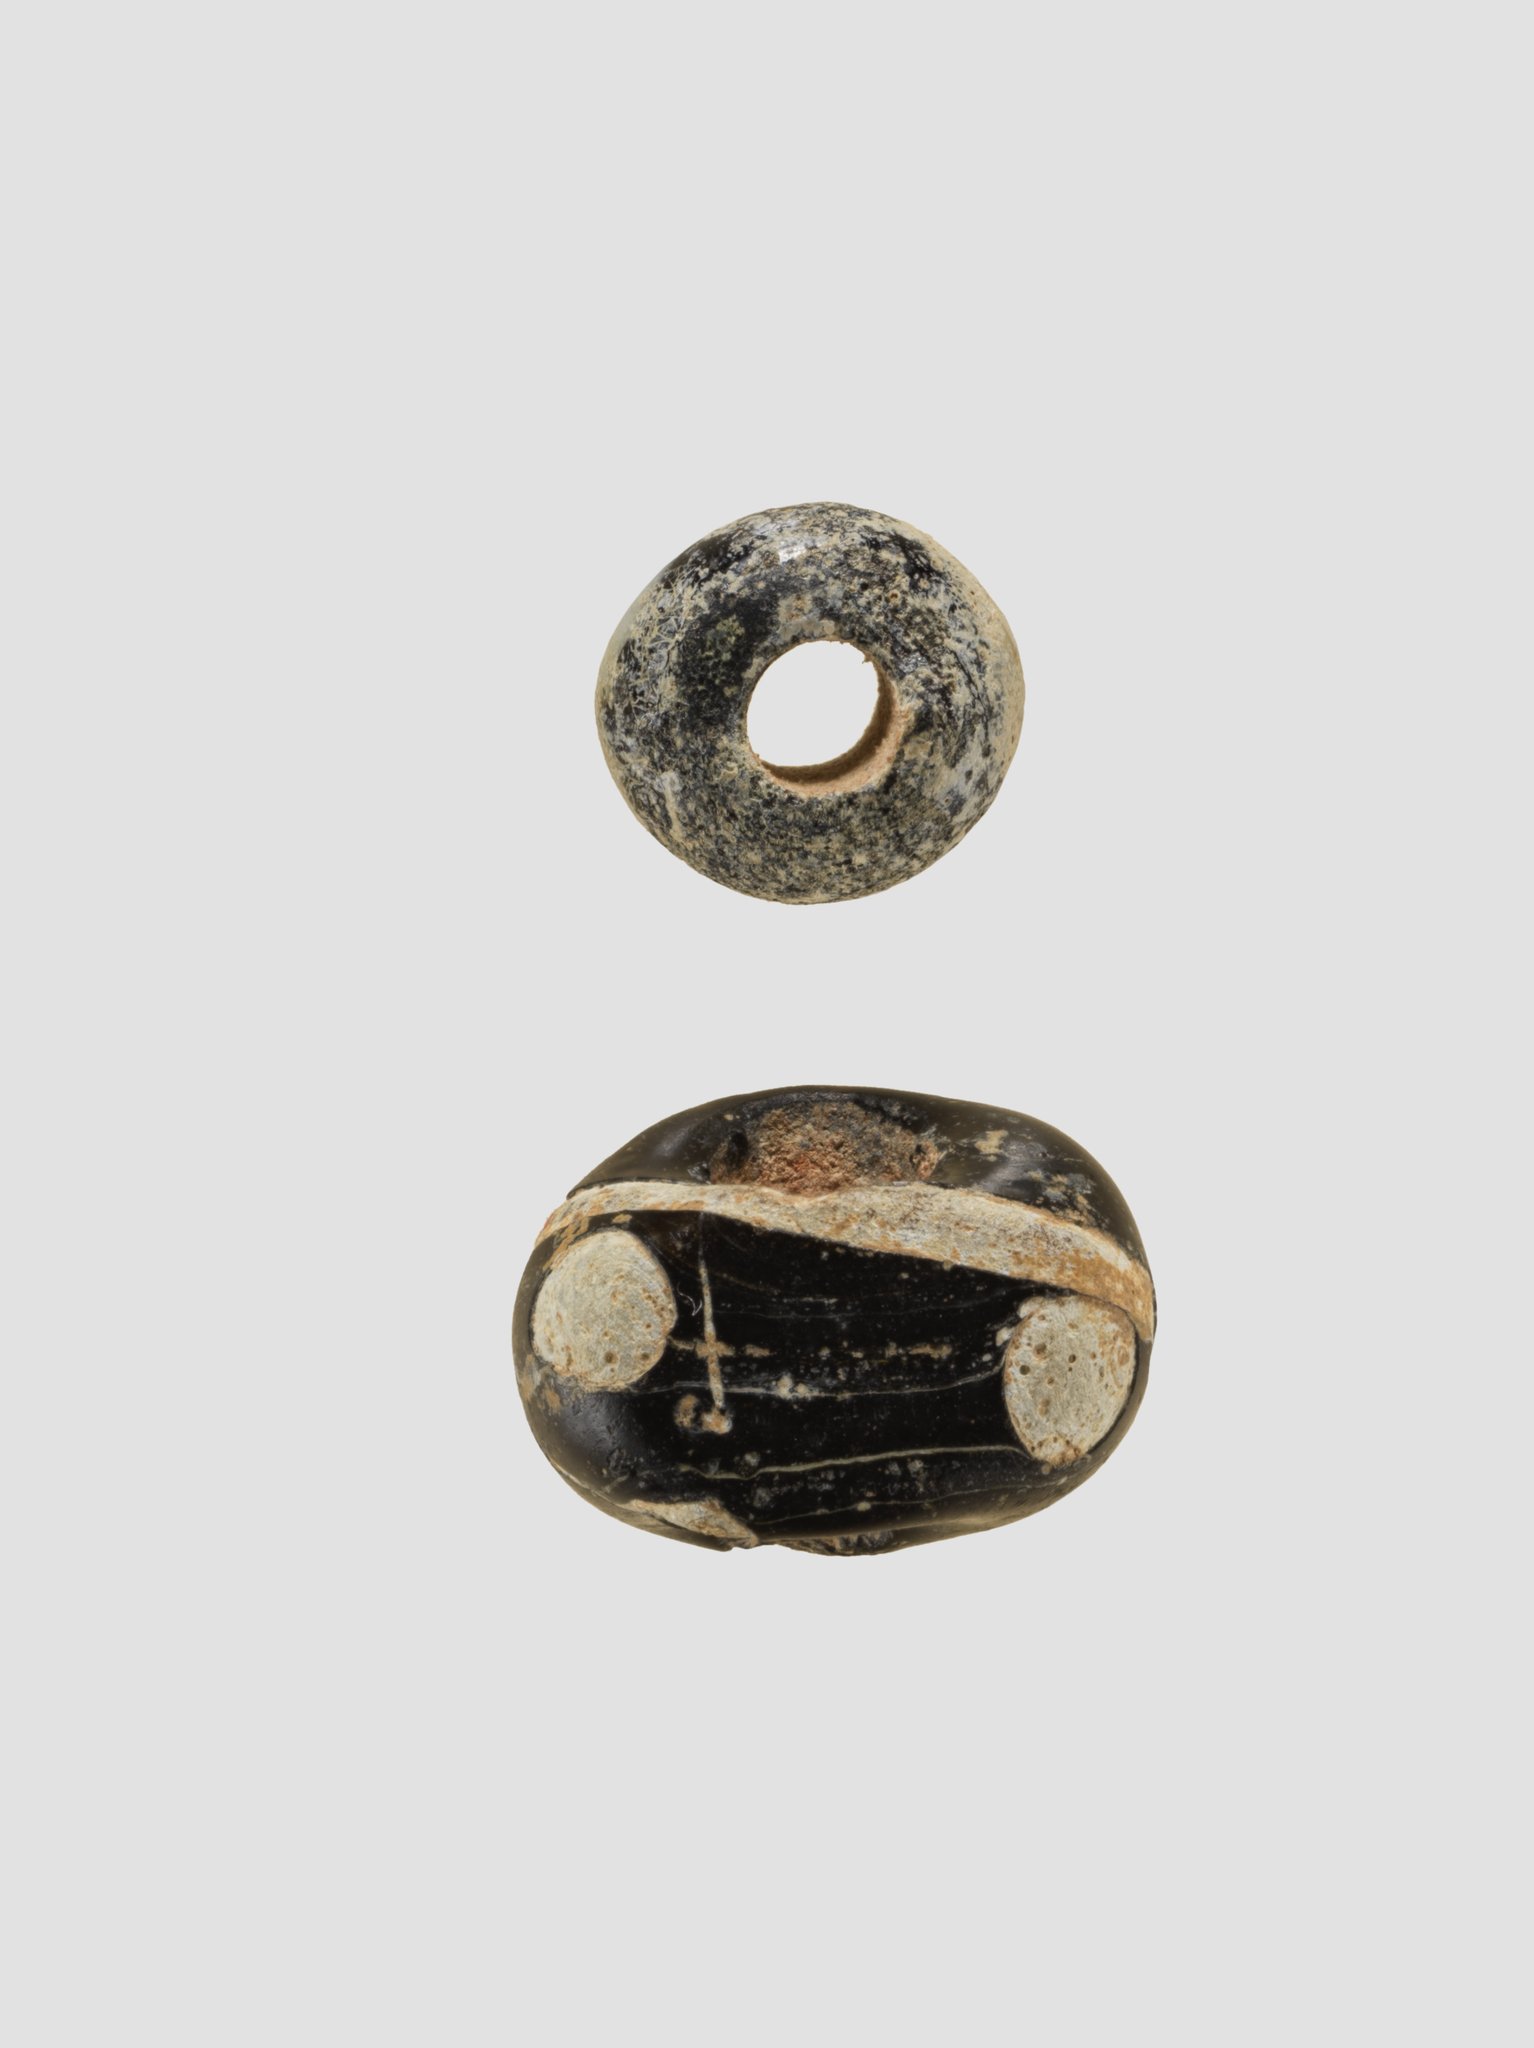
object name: bead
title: Beads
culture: parthian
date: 1-100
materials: glass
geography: iran